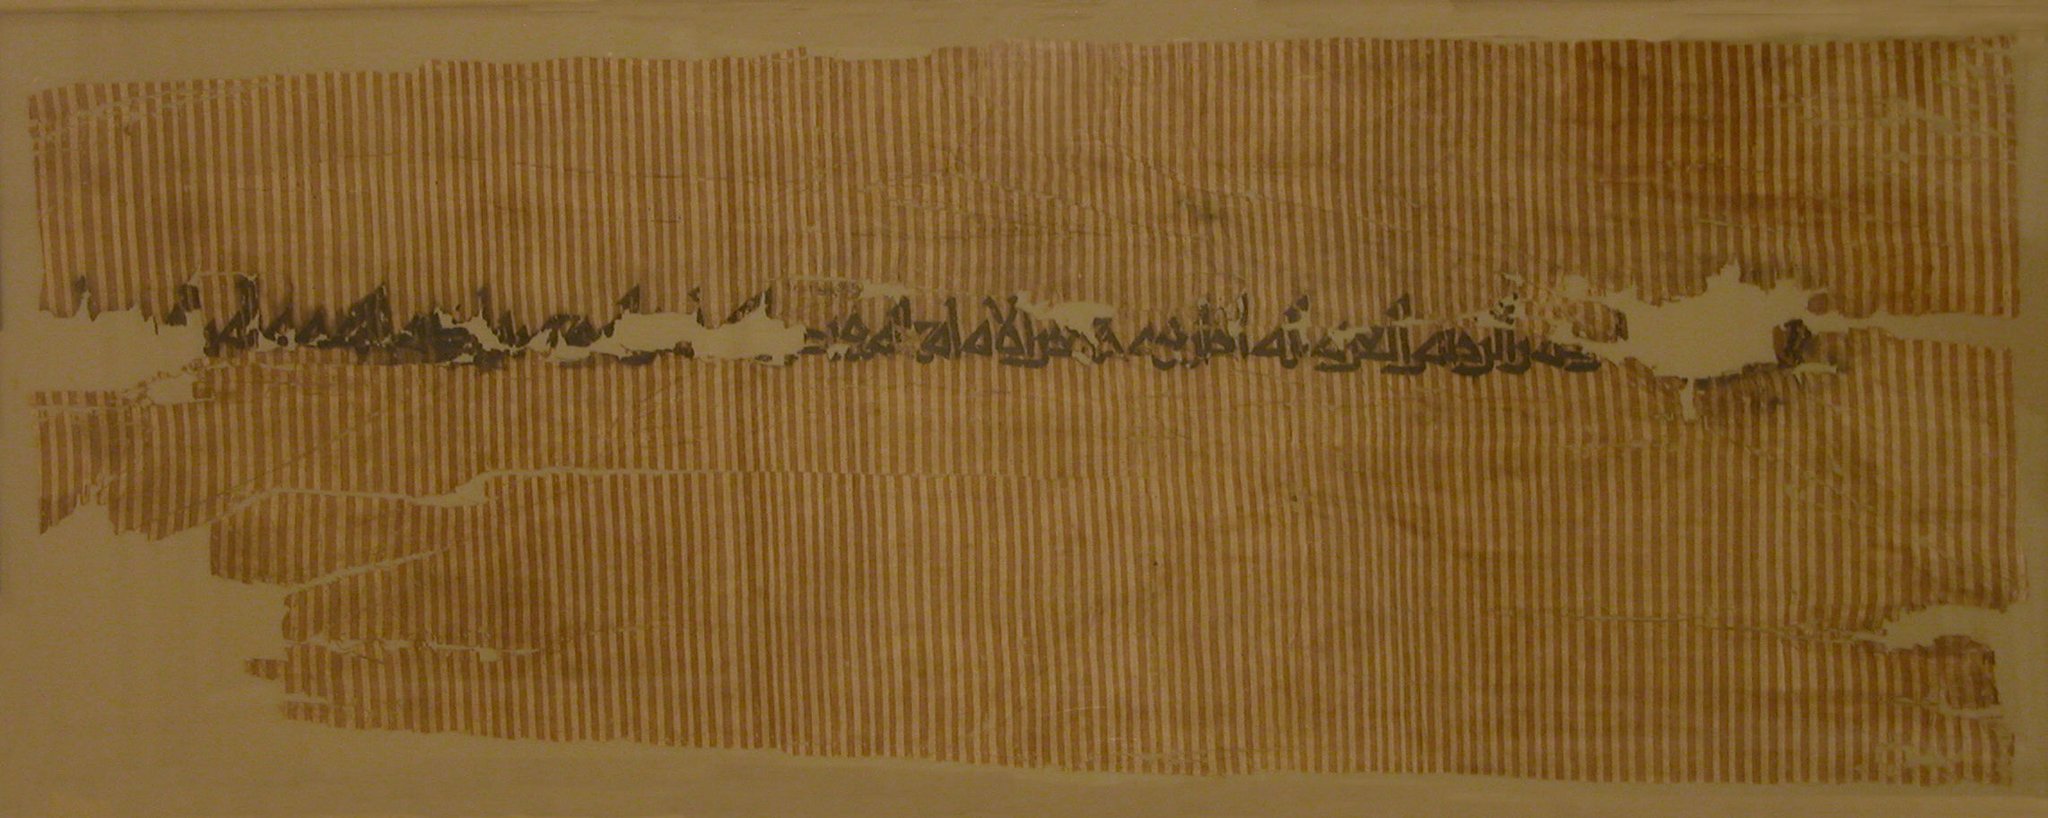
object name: tiraz fragment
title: Tiraz Textile Fragment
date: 901-1000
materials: silk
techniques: embroidery, weave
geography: iran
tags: arabic